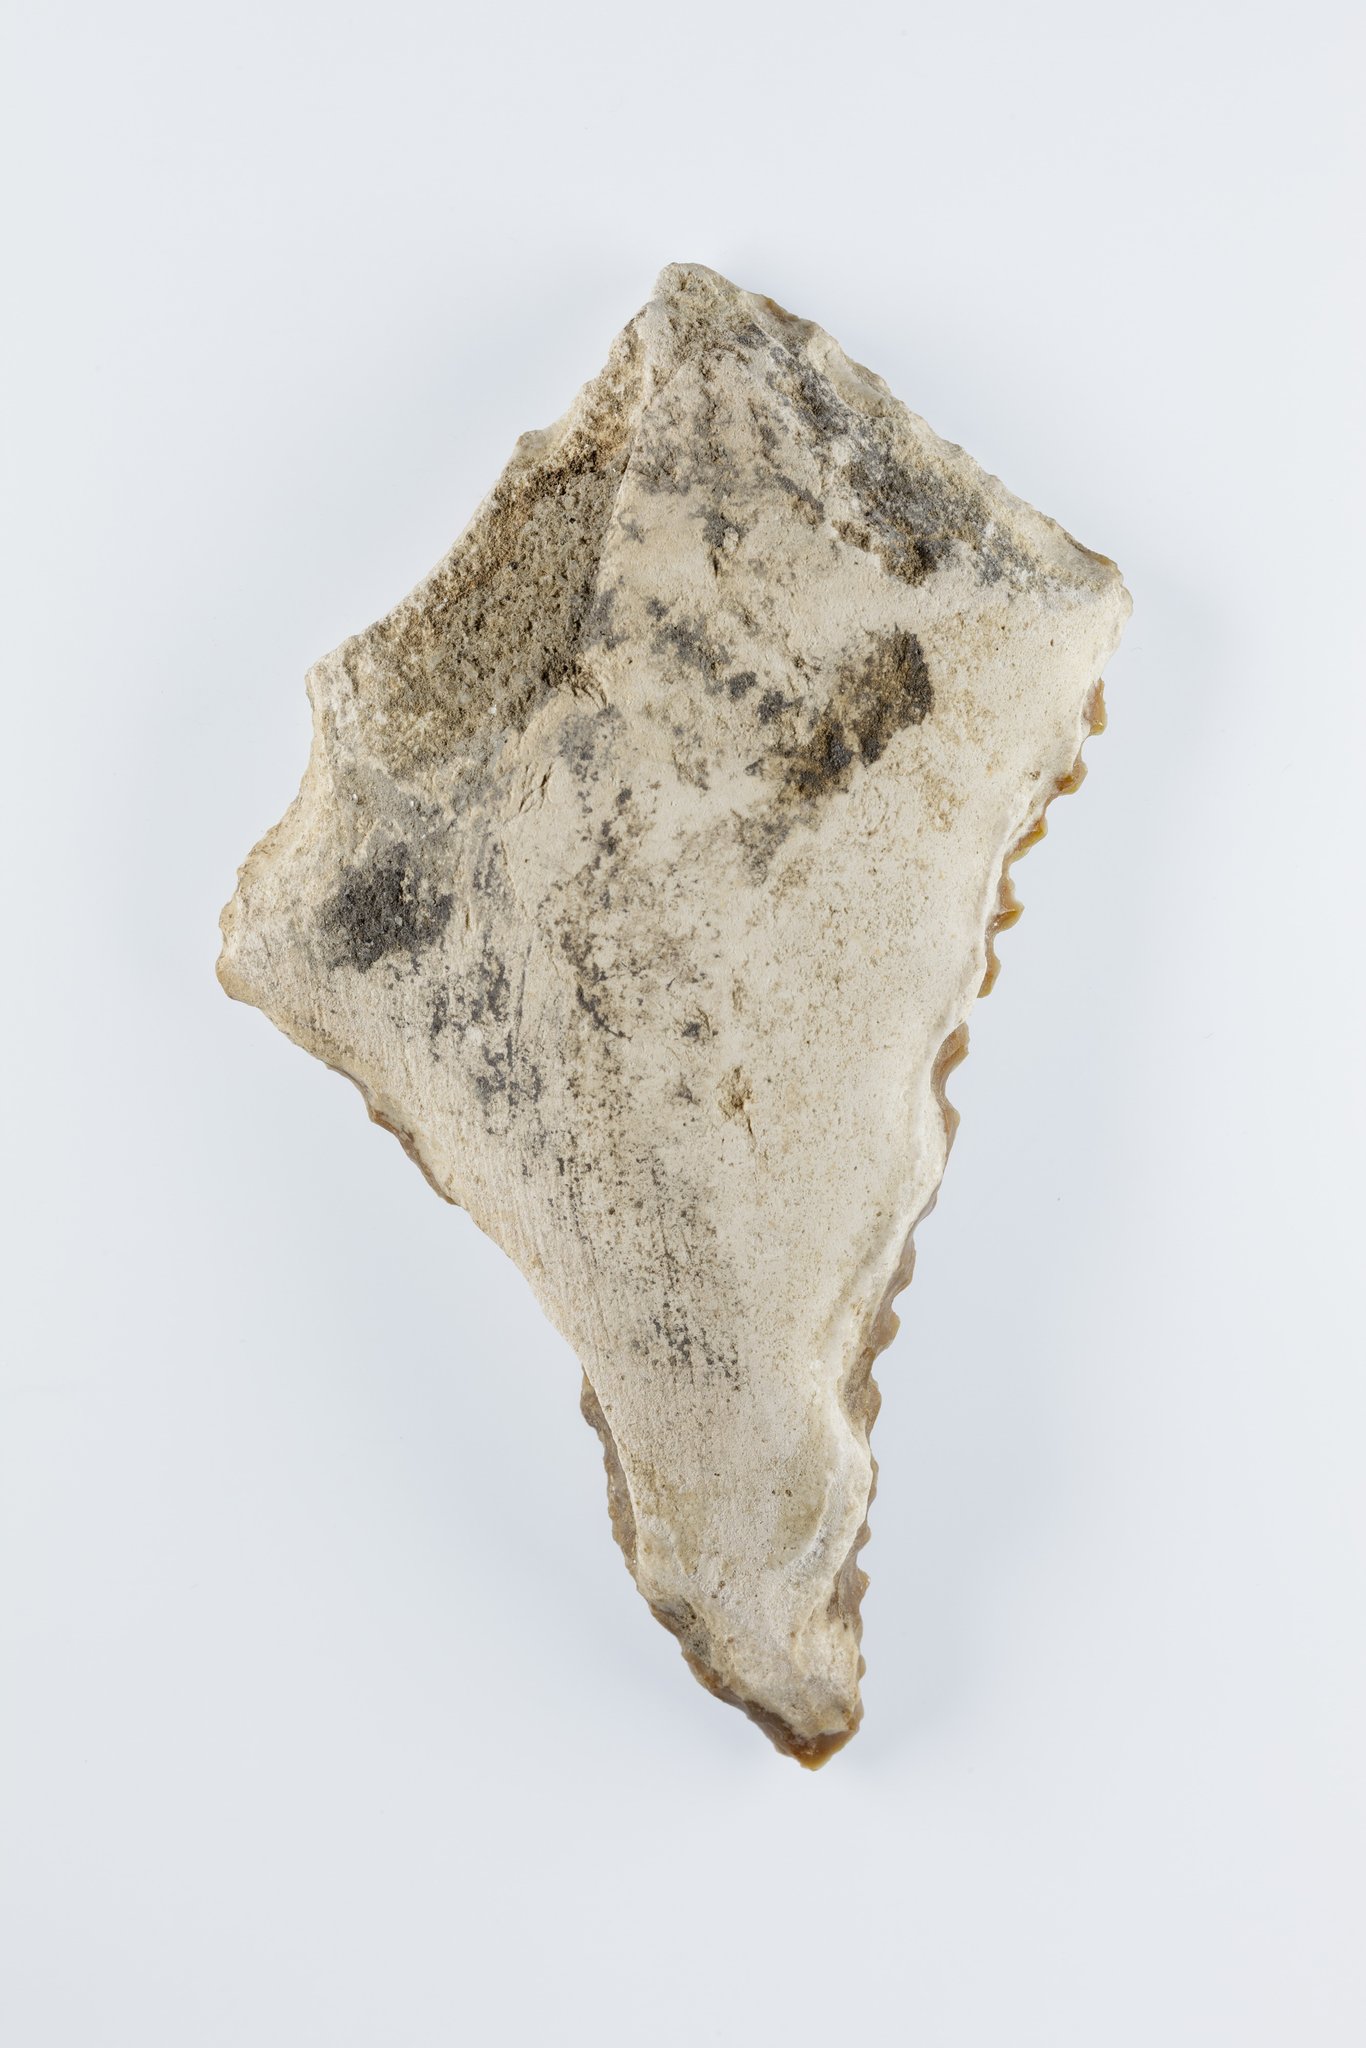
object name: sickle, denticulate, truncated, backed, geometric, tool, element, adhesive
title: Sickle Insert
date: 1184-664 BCE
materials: stone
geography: egypt